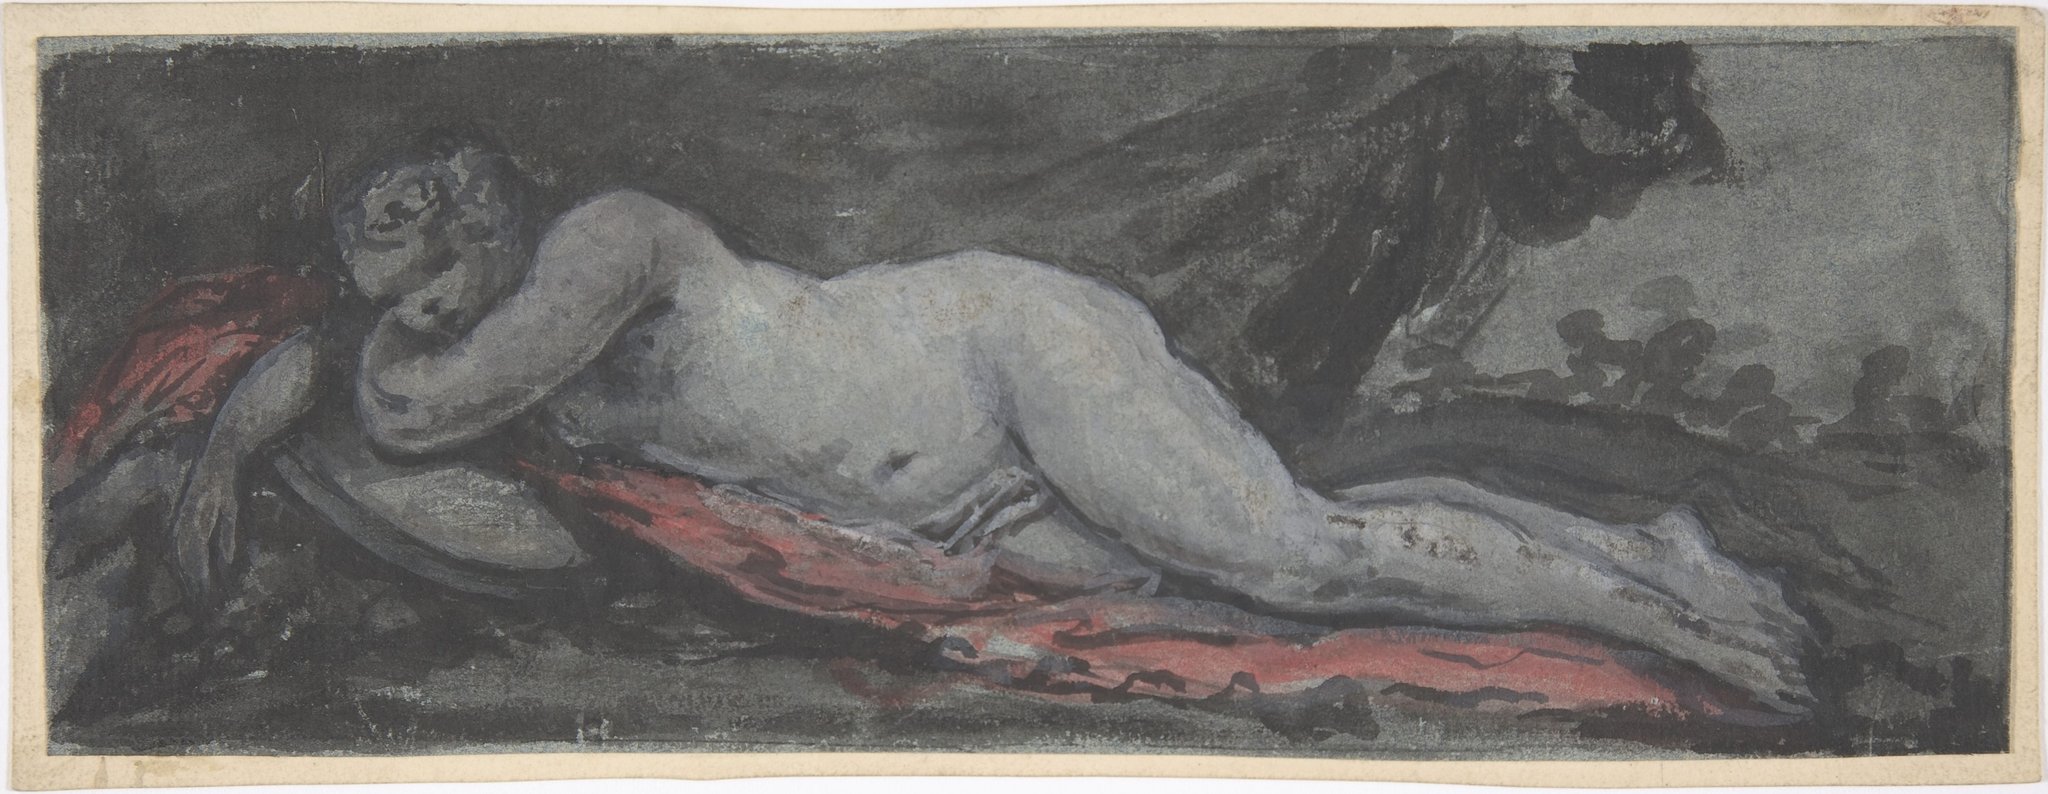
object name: drawing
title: Reclining Nude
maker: anonymous, french, 18th century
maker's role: artist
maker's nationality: french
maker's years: 1700-1800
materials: paint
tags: female nudes